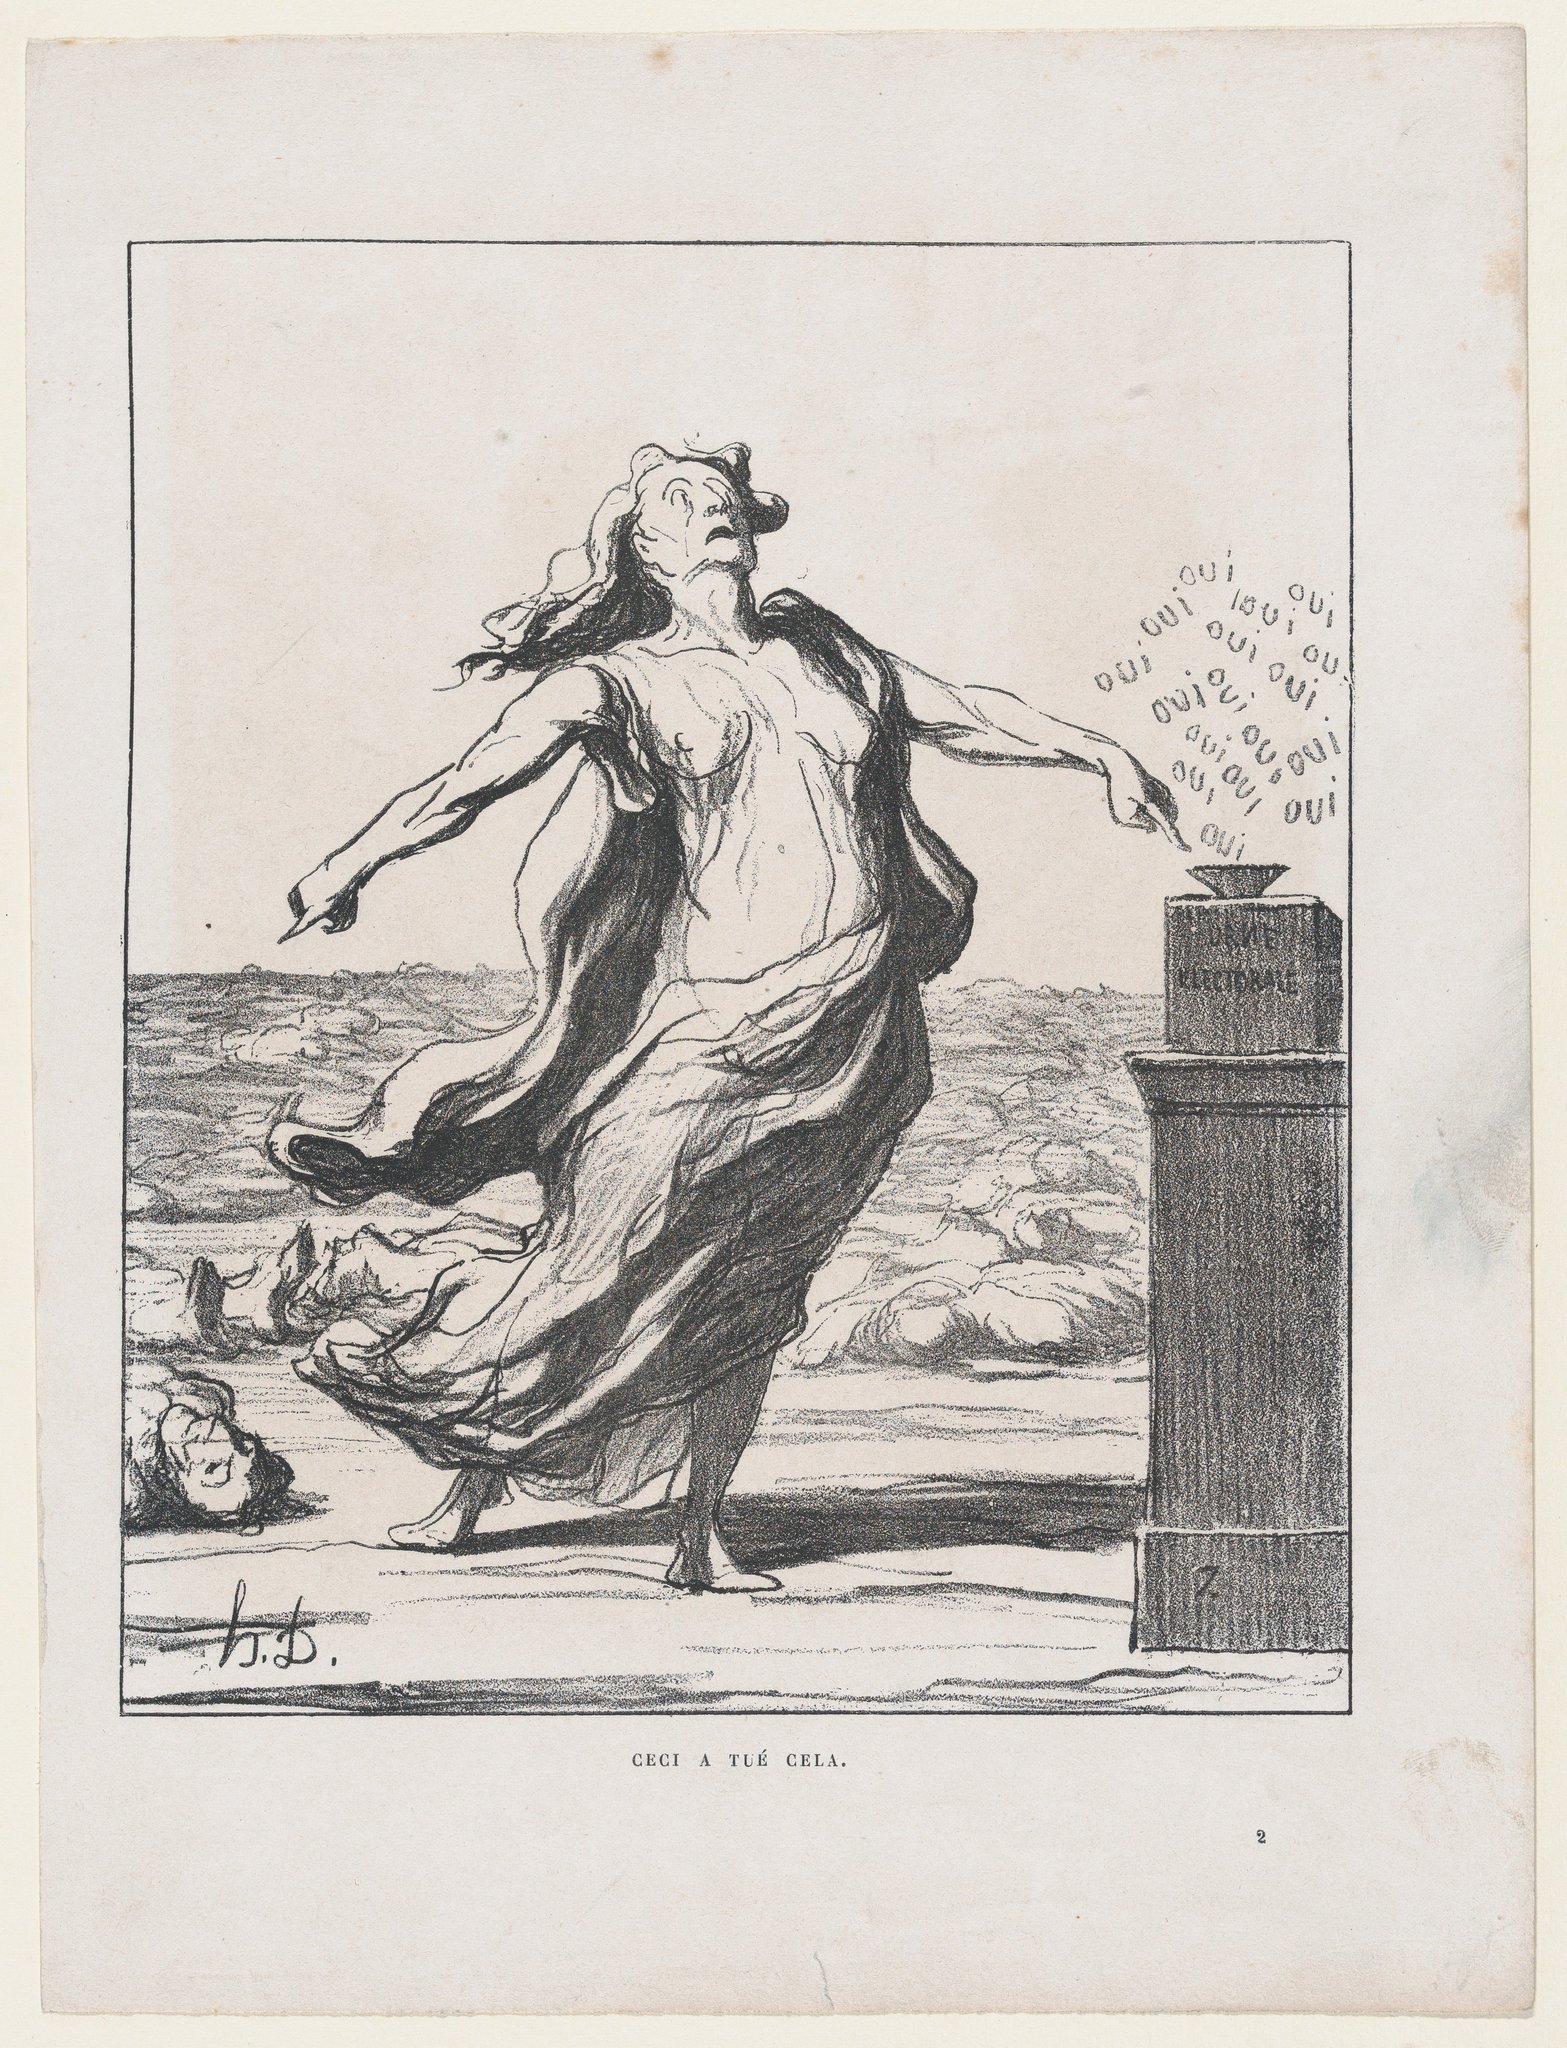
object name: print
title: These are responsible for those, from 'News of the day,' published in "Le Charivari"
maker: honoré daumier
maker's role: artist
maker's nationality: french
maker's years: 1808-1879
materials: paper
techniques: lithograph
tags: satire,women